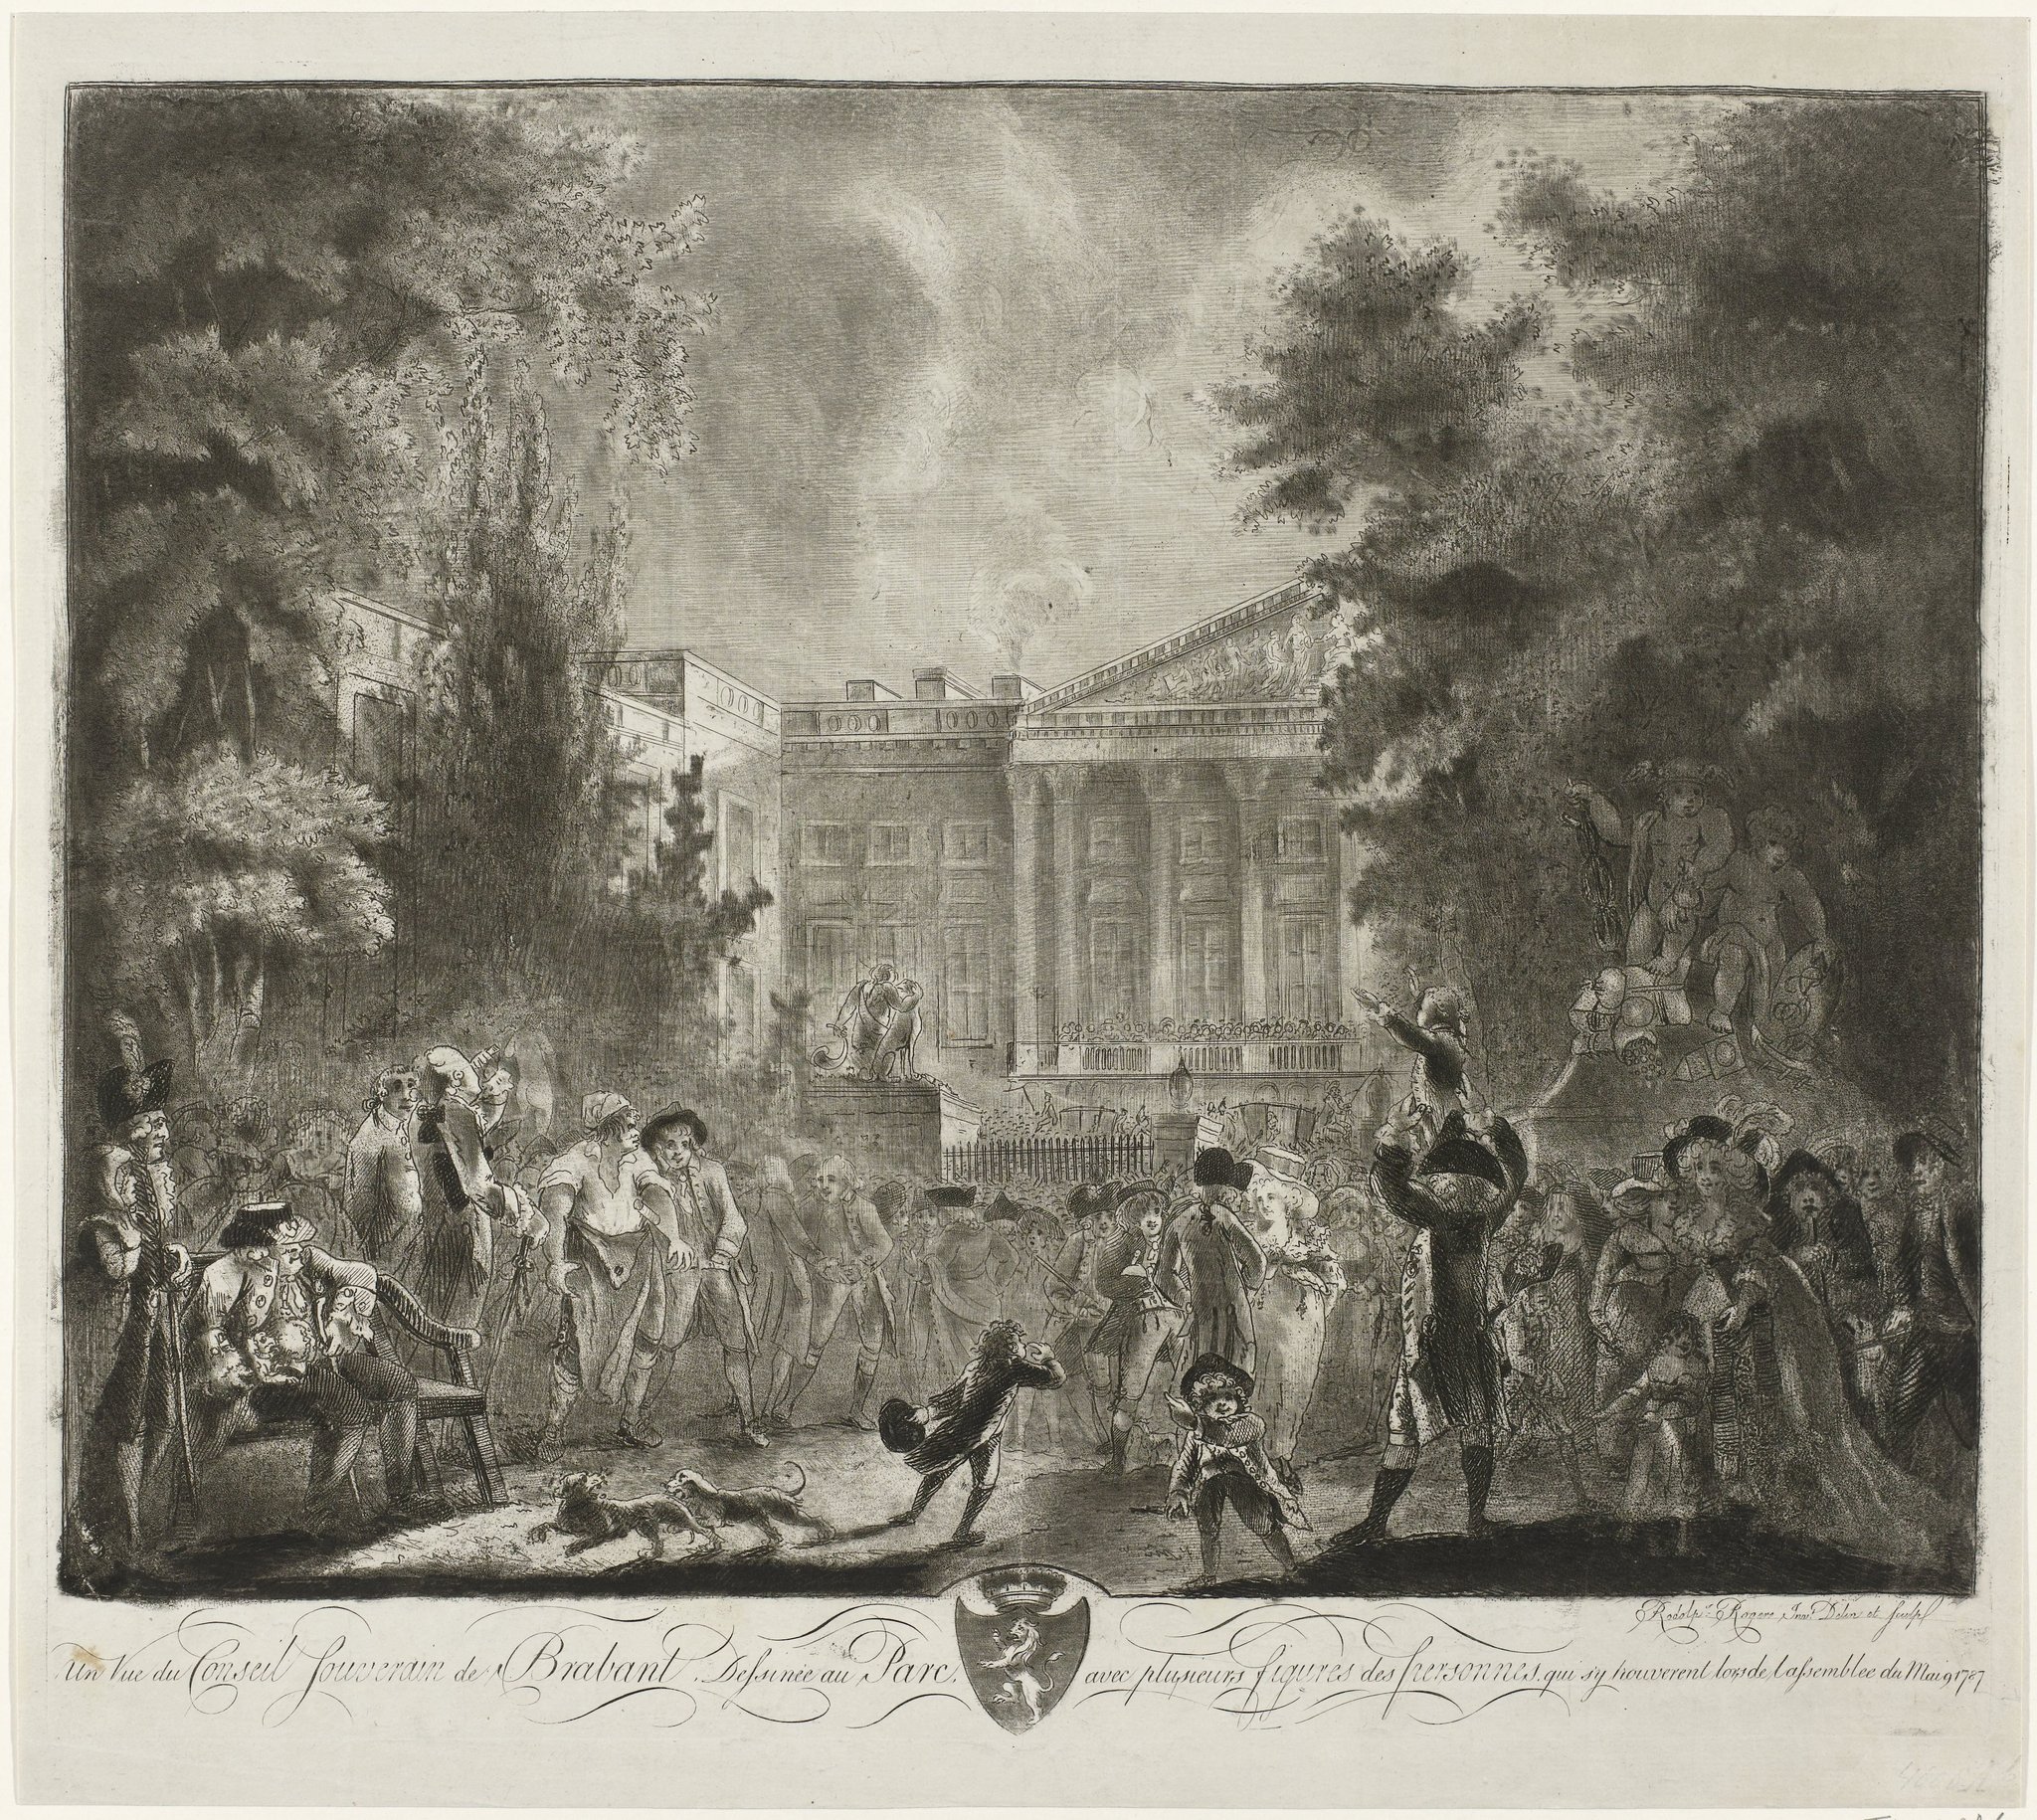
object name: print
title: Un Vue du Conseil Souverain de Brabant, Dessinée au Parc avec plusiers figures des personnes, qui sý trouverent lors de l'assemblee du Mai 9 1787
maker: rodolphus rogers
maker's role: designer, print maker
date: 1787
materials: paper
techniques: engraving, etching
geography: brussels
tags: festivities on events of national importance, brussels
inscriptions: collector's mark: Lugt 2228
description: Feestende mensenmassa verzameld voor de Soevereine Raad van Brabant in Brussel, 9 mei 1787. In het onderschrift het wapen van Brabant. Met pendant.